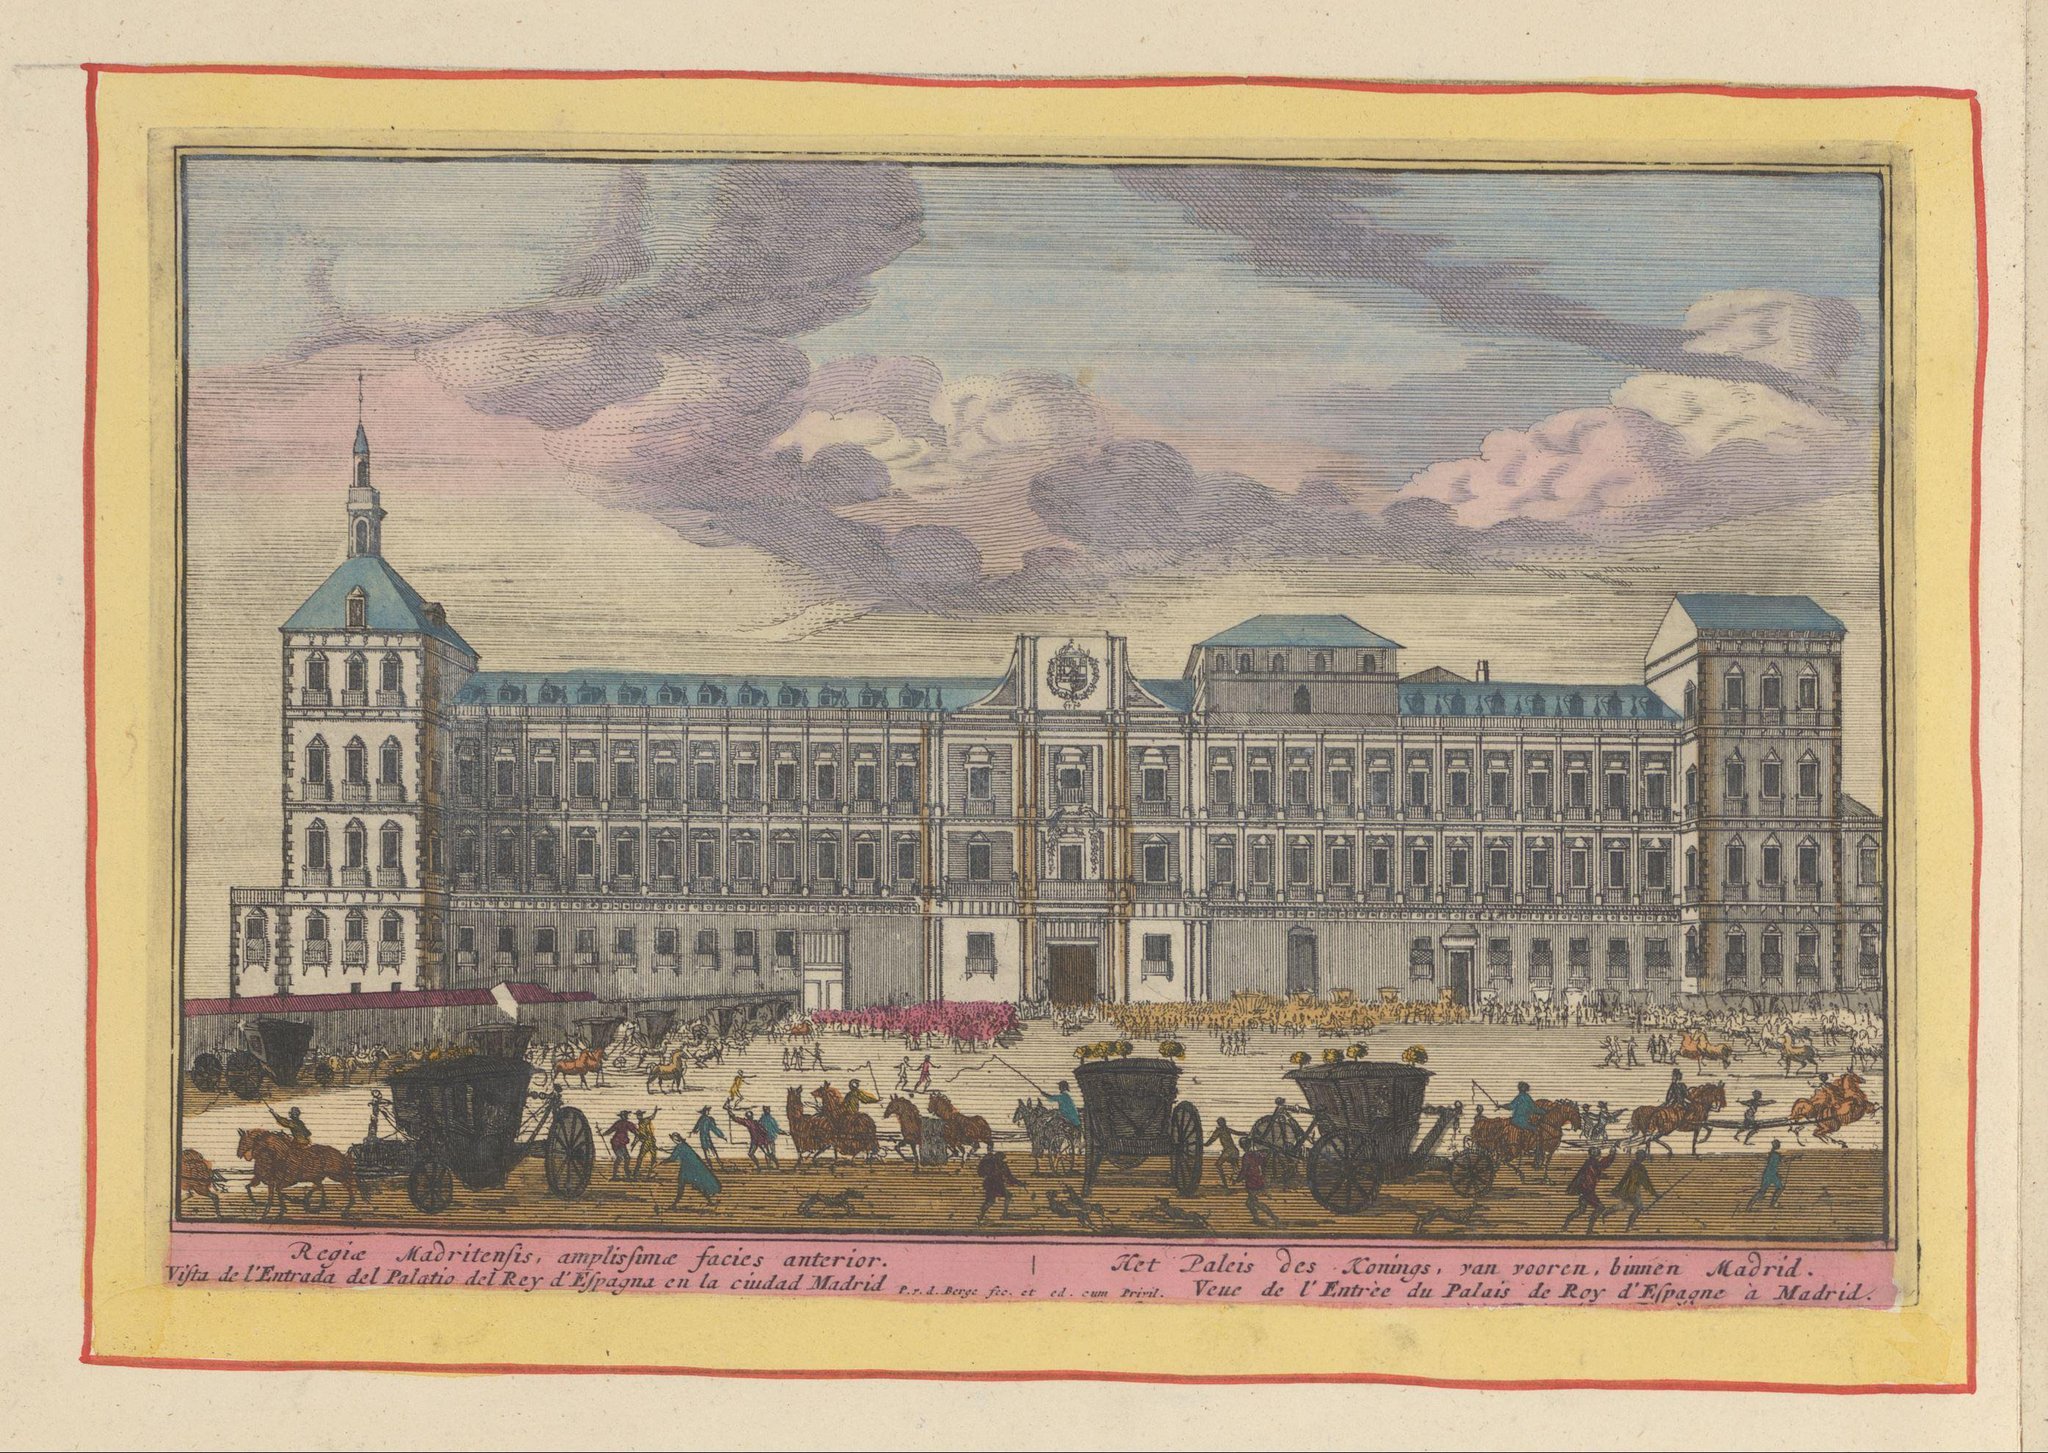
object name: book illustration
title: Vooraanzicht van het Koninklijk Paleis te Madrid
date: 1694-1737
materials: paper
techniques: etching, hand coloring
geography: the hague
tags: palace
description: Prent uit: Theatrum Hispaniæ, exhibens regni urbes, villas ac viridaria magis illustria. Het aanmerkelykste en voortreffelykste in Spanjen (...). Amsterdam: Pieter van den Berge, ca. 1694-1737.